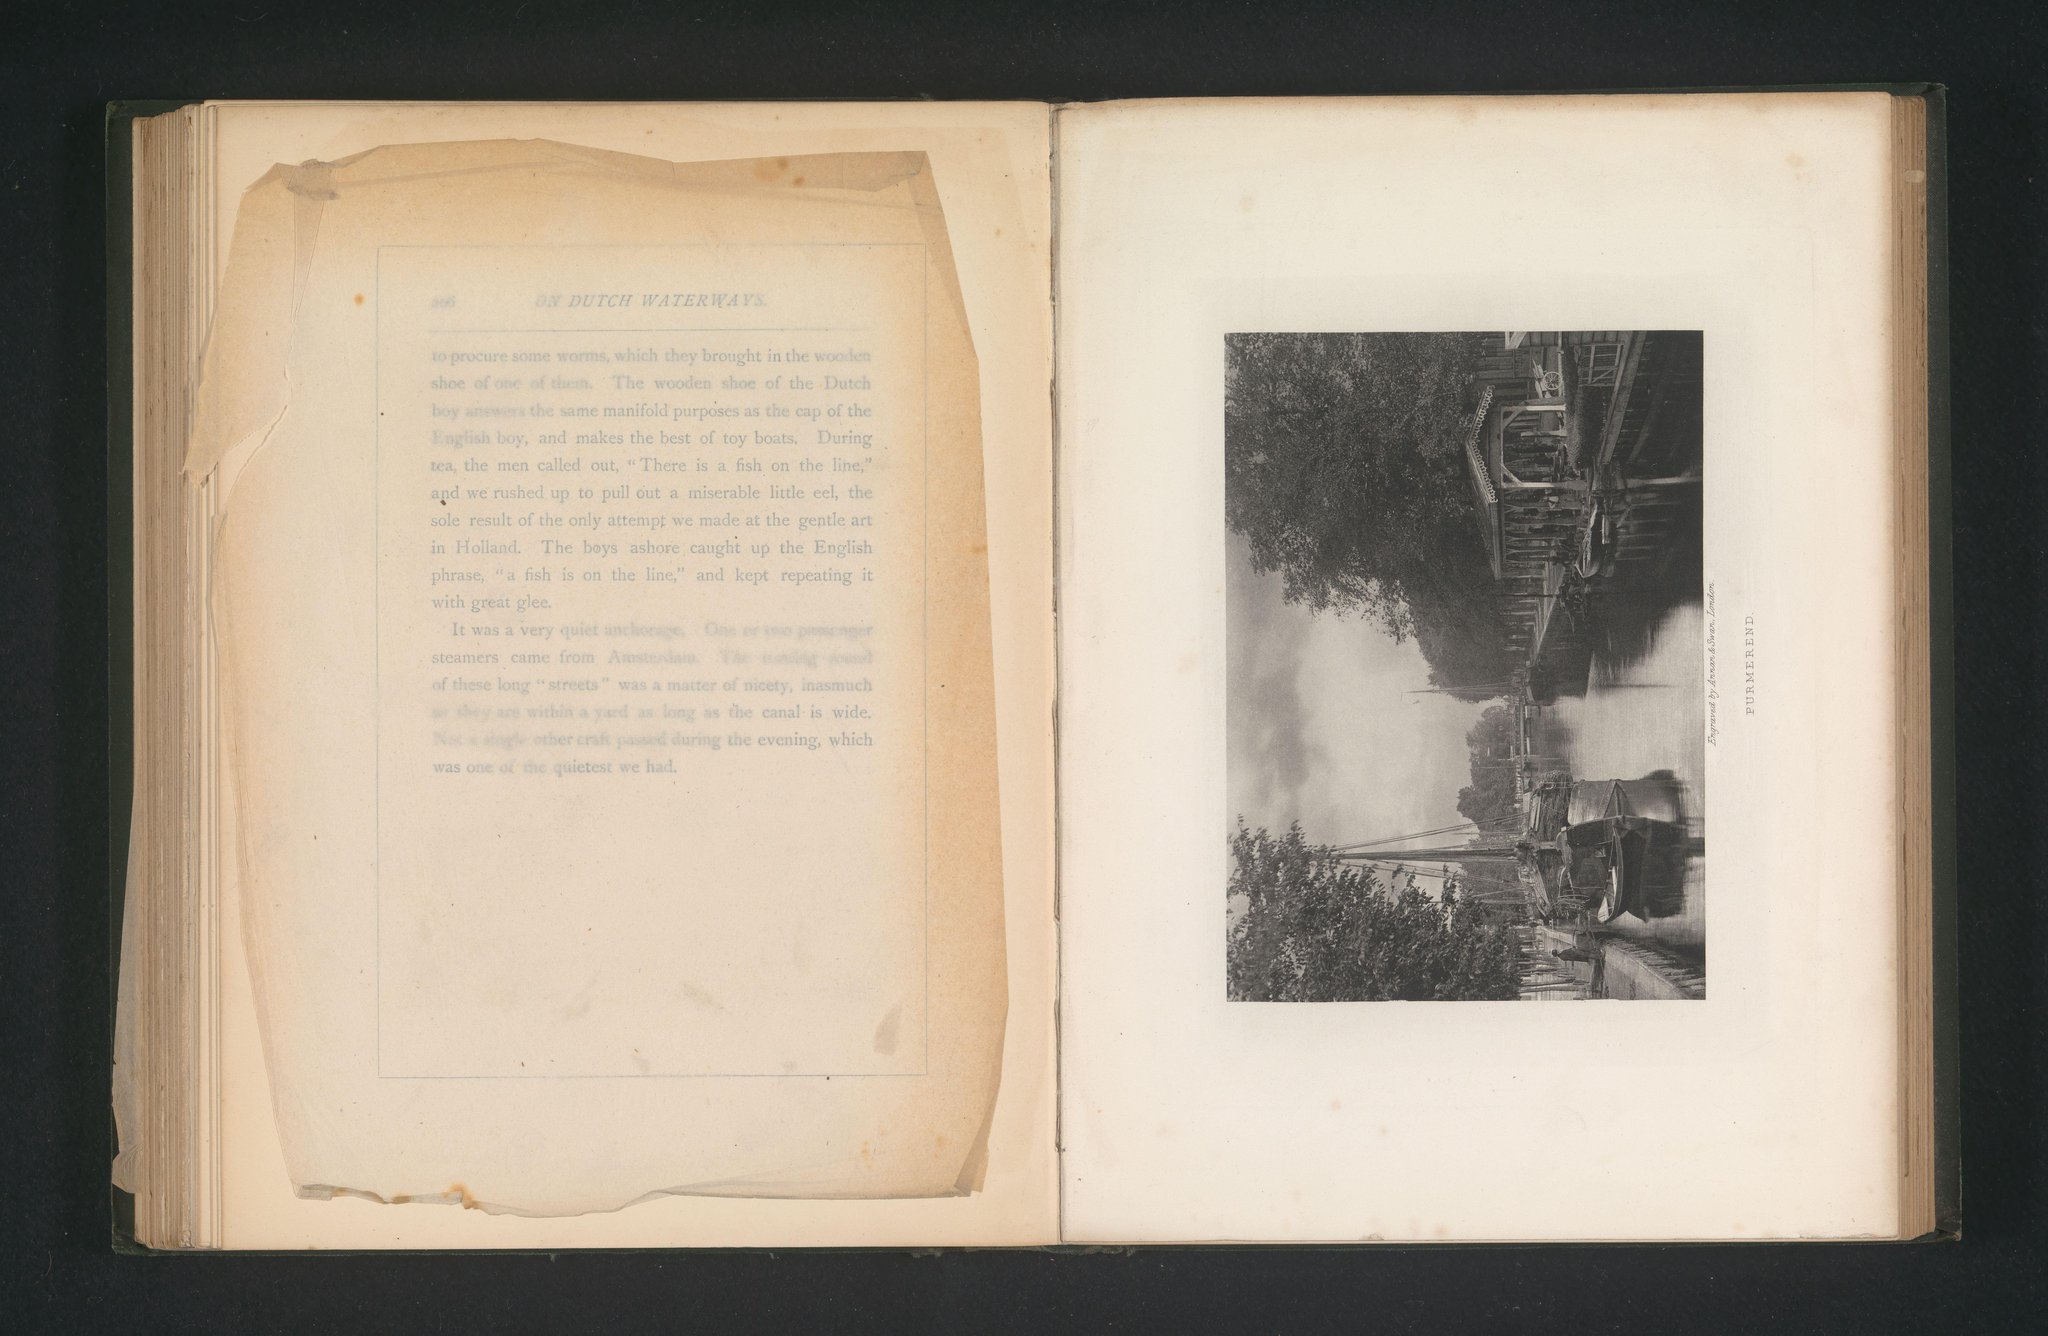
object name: photomechanical print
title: Purmerend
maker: george christopher davies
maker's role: fotograaf, geoloog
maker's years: 1849-1922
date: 1881-1886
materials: paper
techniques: photoaquatint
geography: purmerend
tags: harbour, sailing-ship, sailing-boat, prospect of city, town panorama, silhouette of city